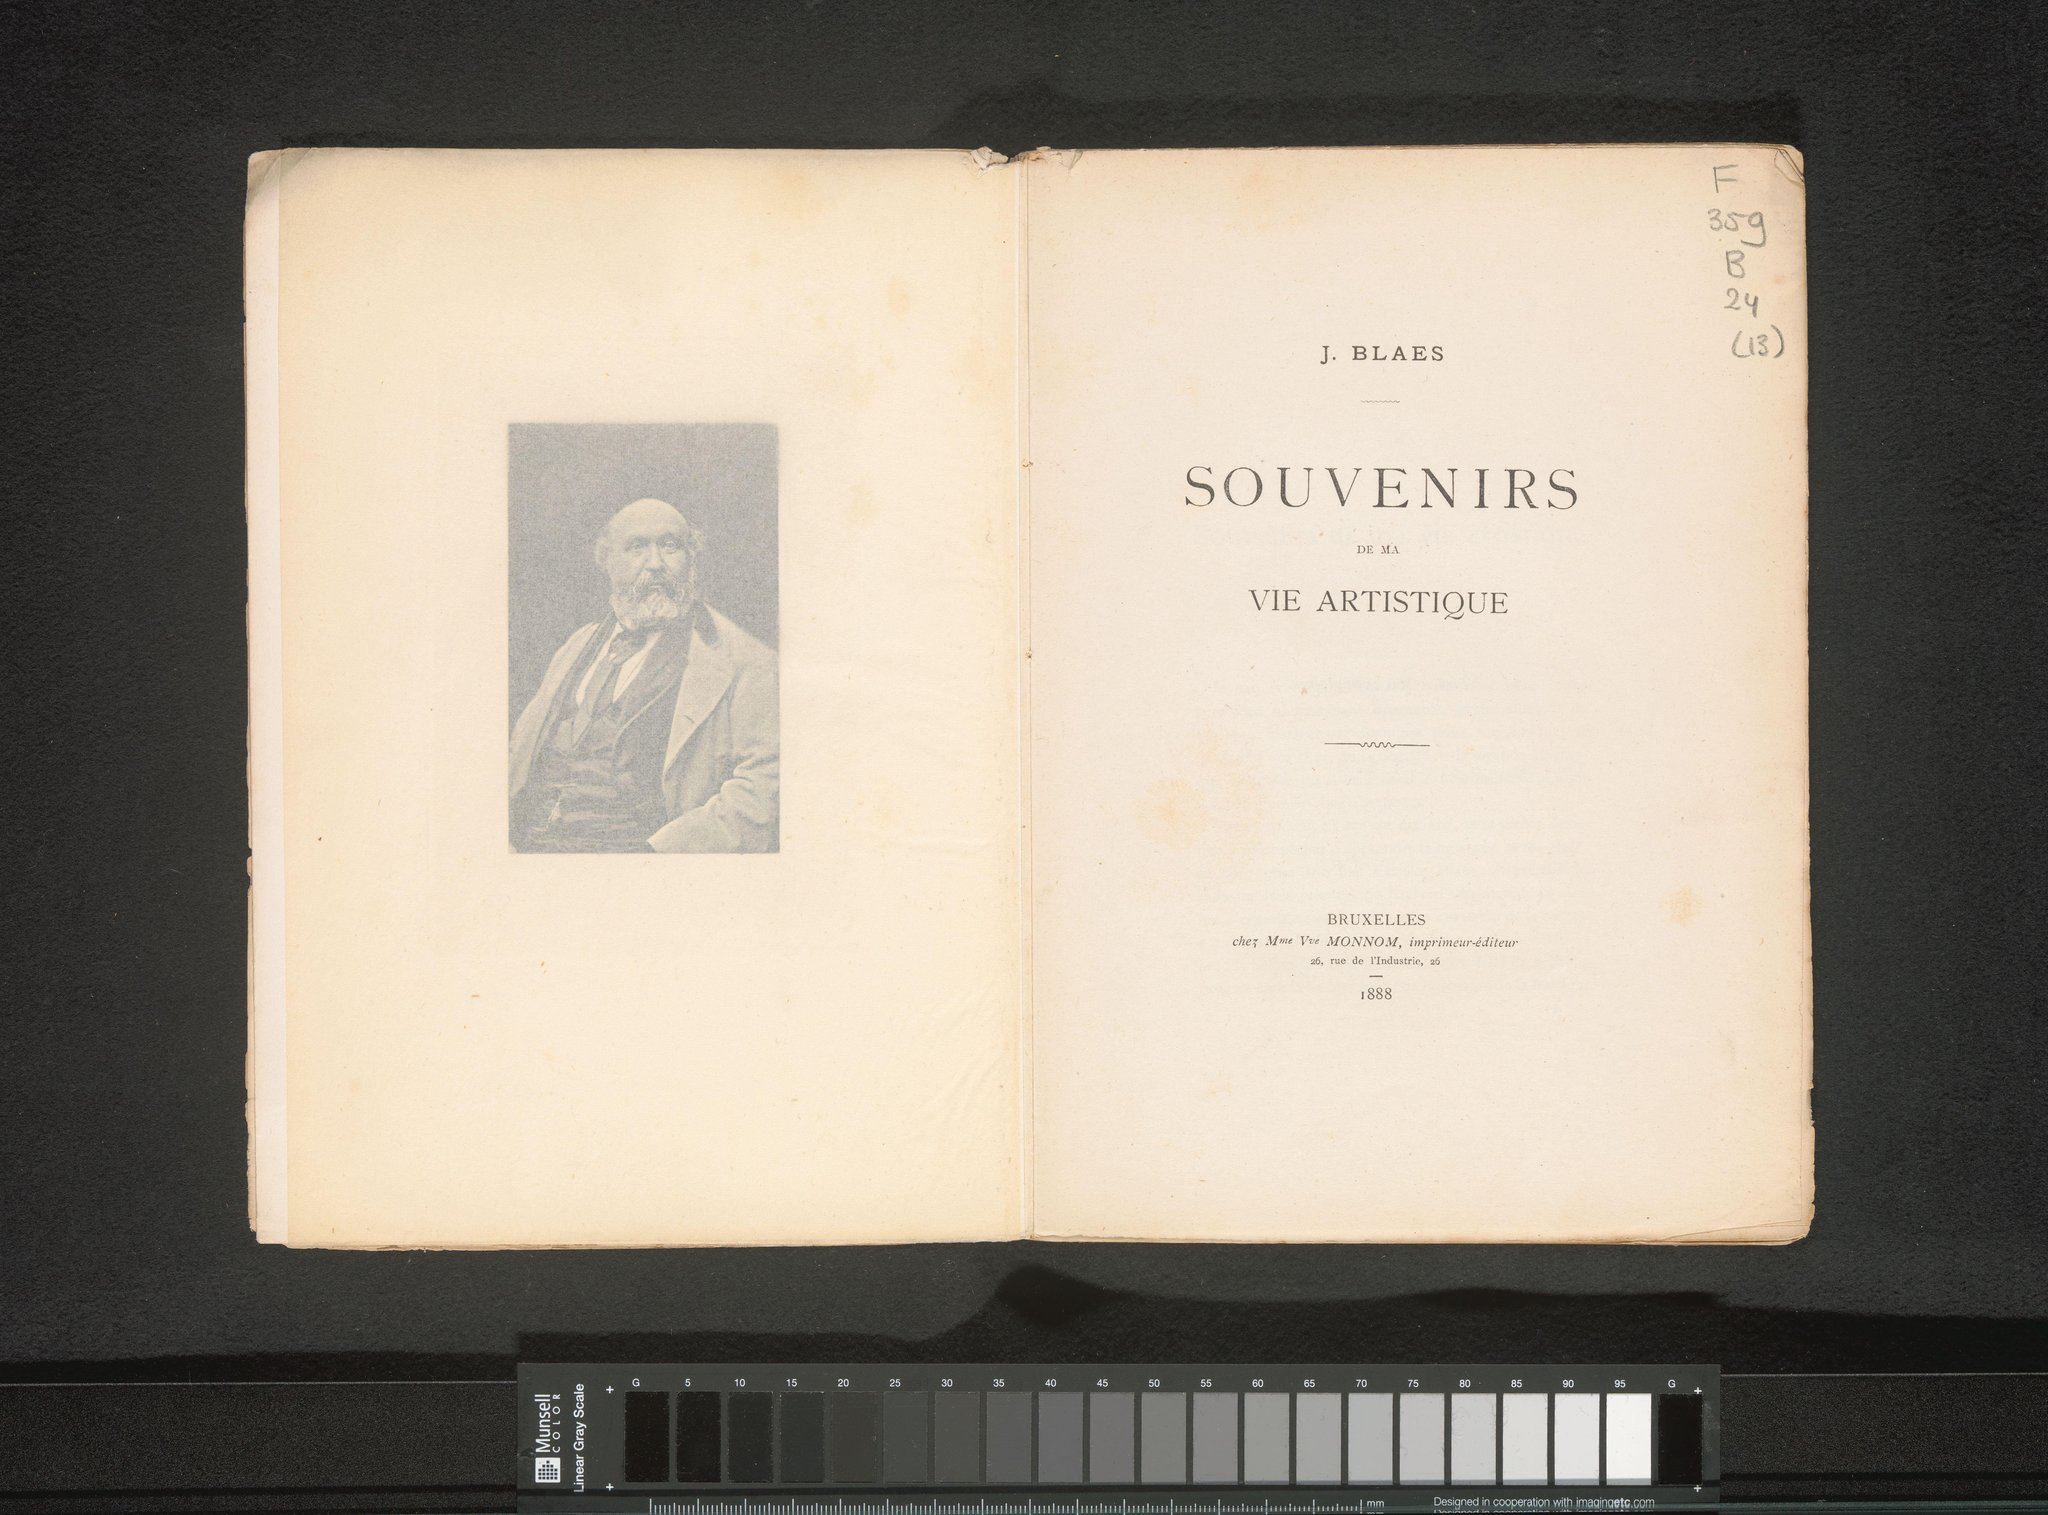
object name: book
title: Souvenirs de ma vie artistique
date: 1888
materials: paper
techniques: photoaquatint, printing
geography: brussels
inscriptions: inscription: ‘Hommage de l'auteur a [...]/ [...]’, annotation: ‘JAN 1989’